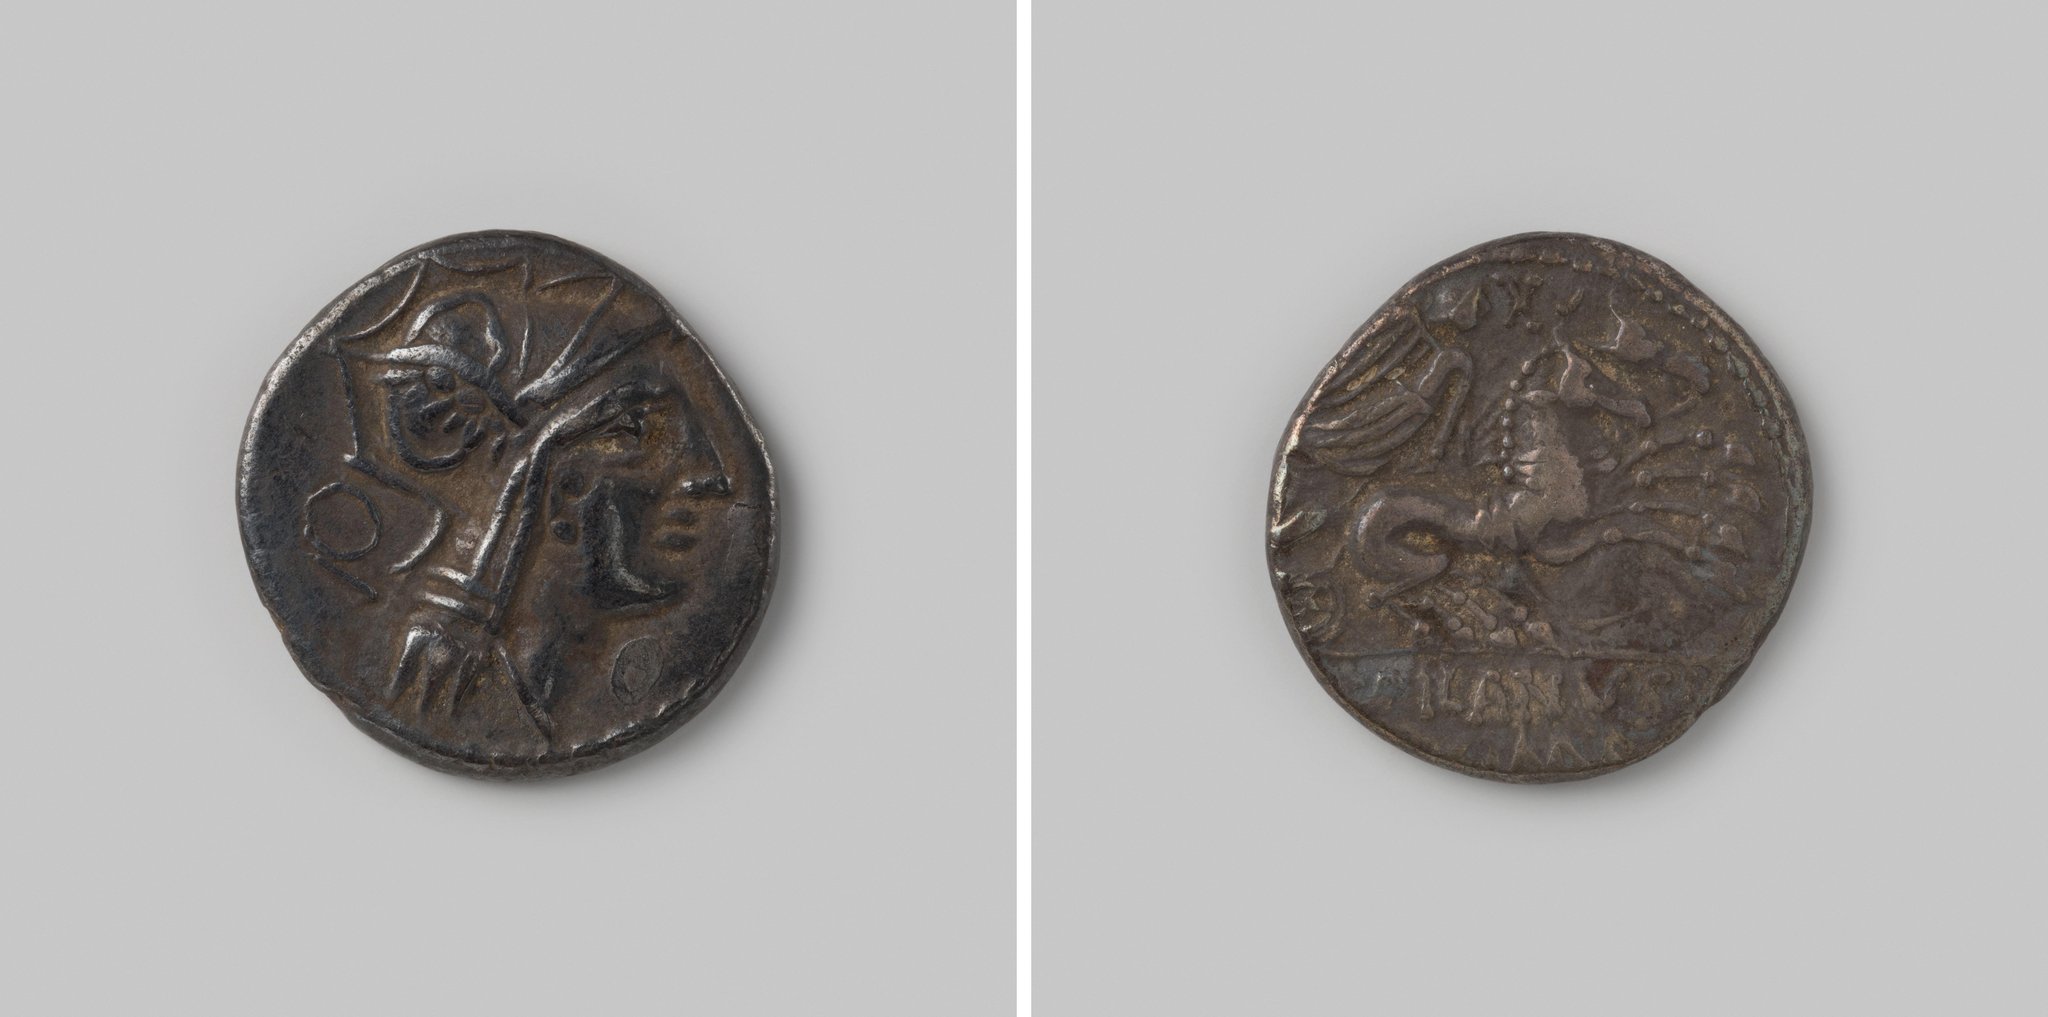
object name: denarius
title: Denarius uit de Romeinse Republiek van monetarius Decimus Junius Silanus, -91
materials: silver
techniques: striking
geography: rome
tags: monetarius, decimus junius silanus, godin, roma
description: Zilveren munt. Voorzijde: hoofd van de godin Roma naar rechts. Keerzijde: de overwinning in een biga (tweespan), in de afsnede de naam van de monetarius Silanus.